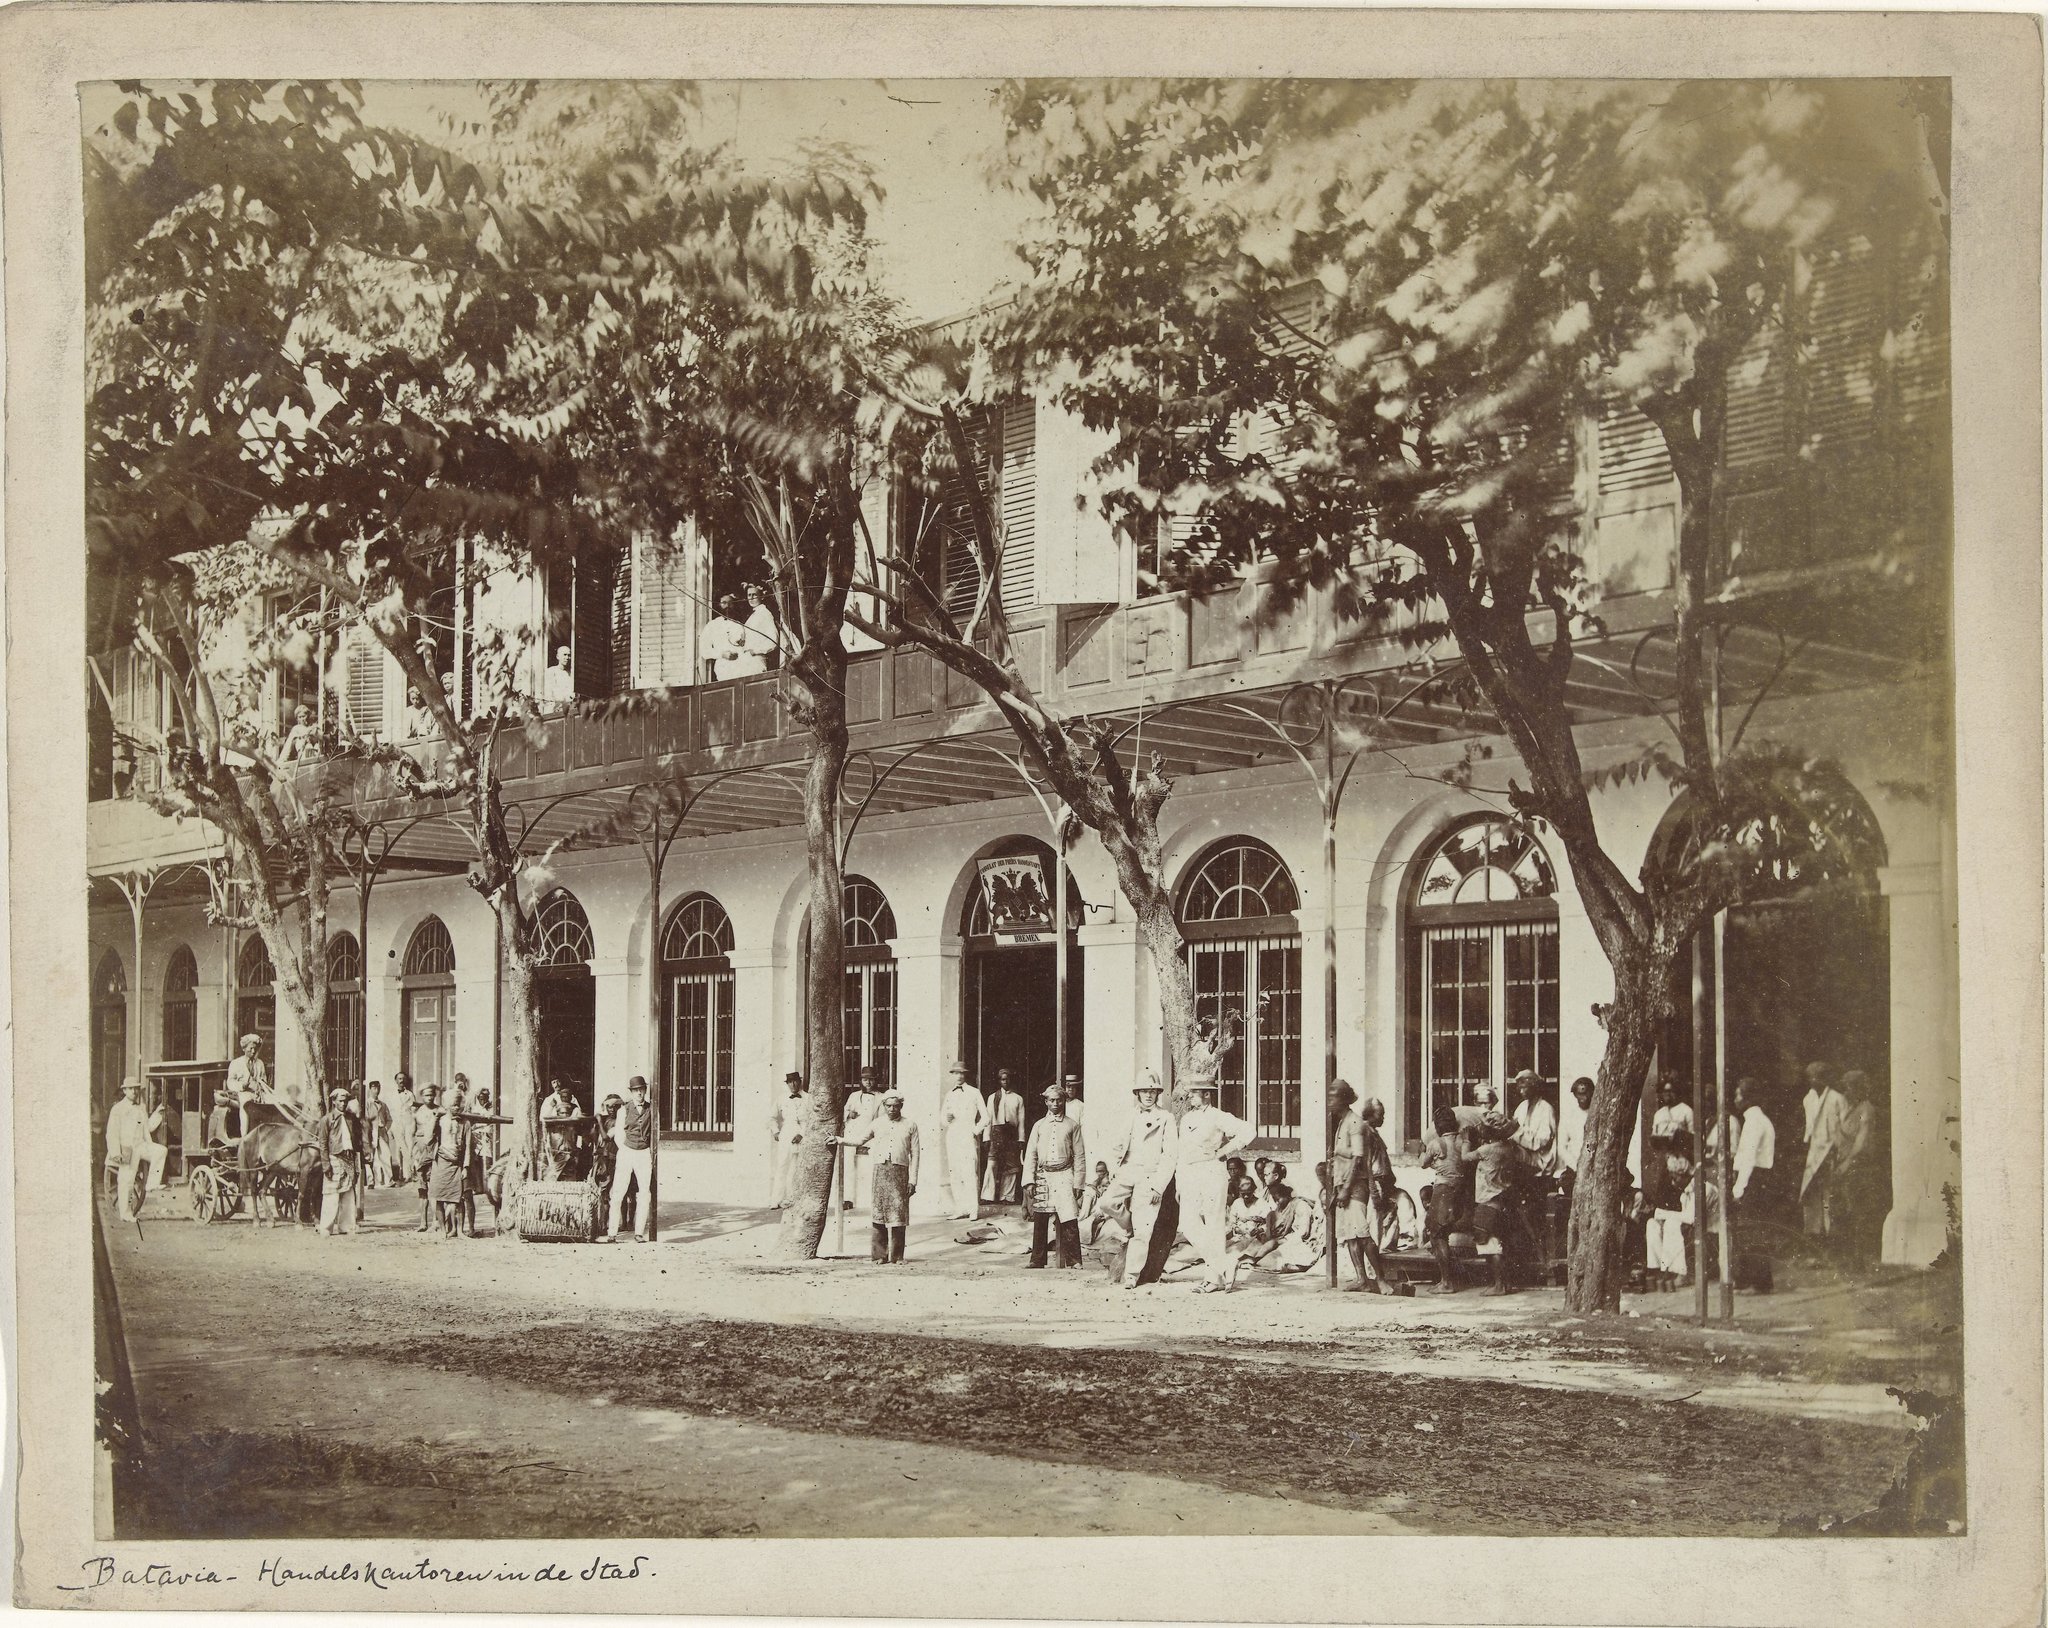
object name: photograph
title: Batavia - Handelskantoren in de stad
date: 1856-1875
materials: cardboard, paper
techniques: albumen print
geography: batavia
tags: consular service, street, batavia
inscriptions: inscription: ‘Batavia - Handelskantoren in de stad’, number: ‘20’, check stamp: ‘Photographieen van Ned. Indië/ W & P/ Batavia’